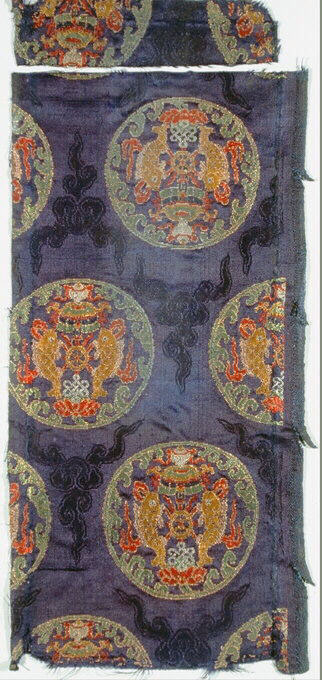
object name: sutra cover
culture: chinese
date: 1601-1800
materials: metal thread, silk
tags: fish